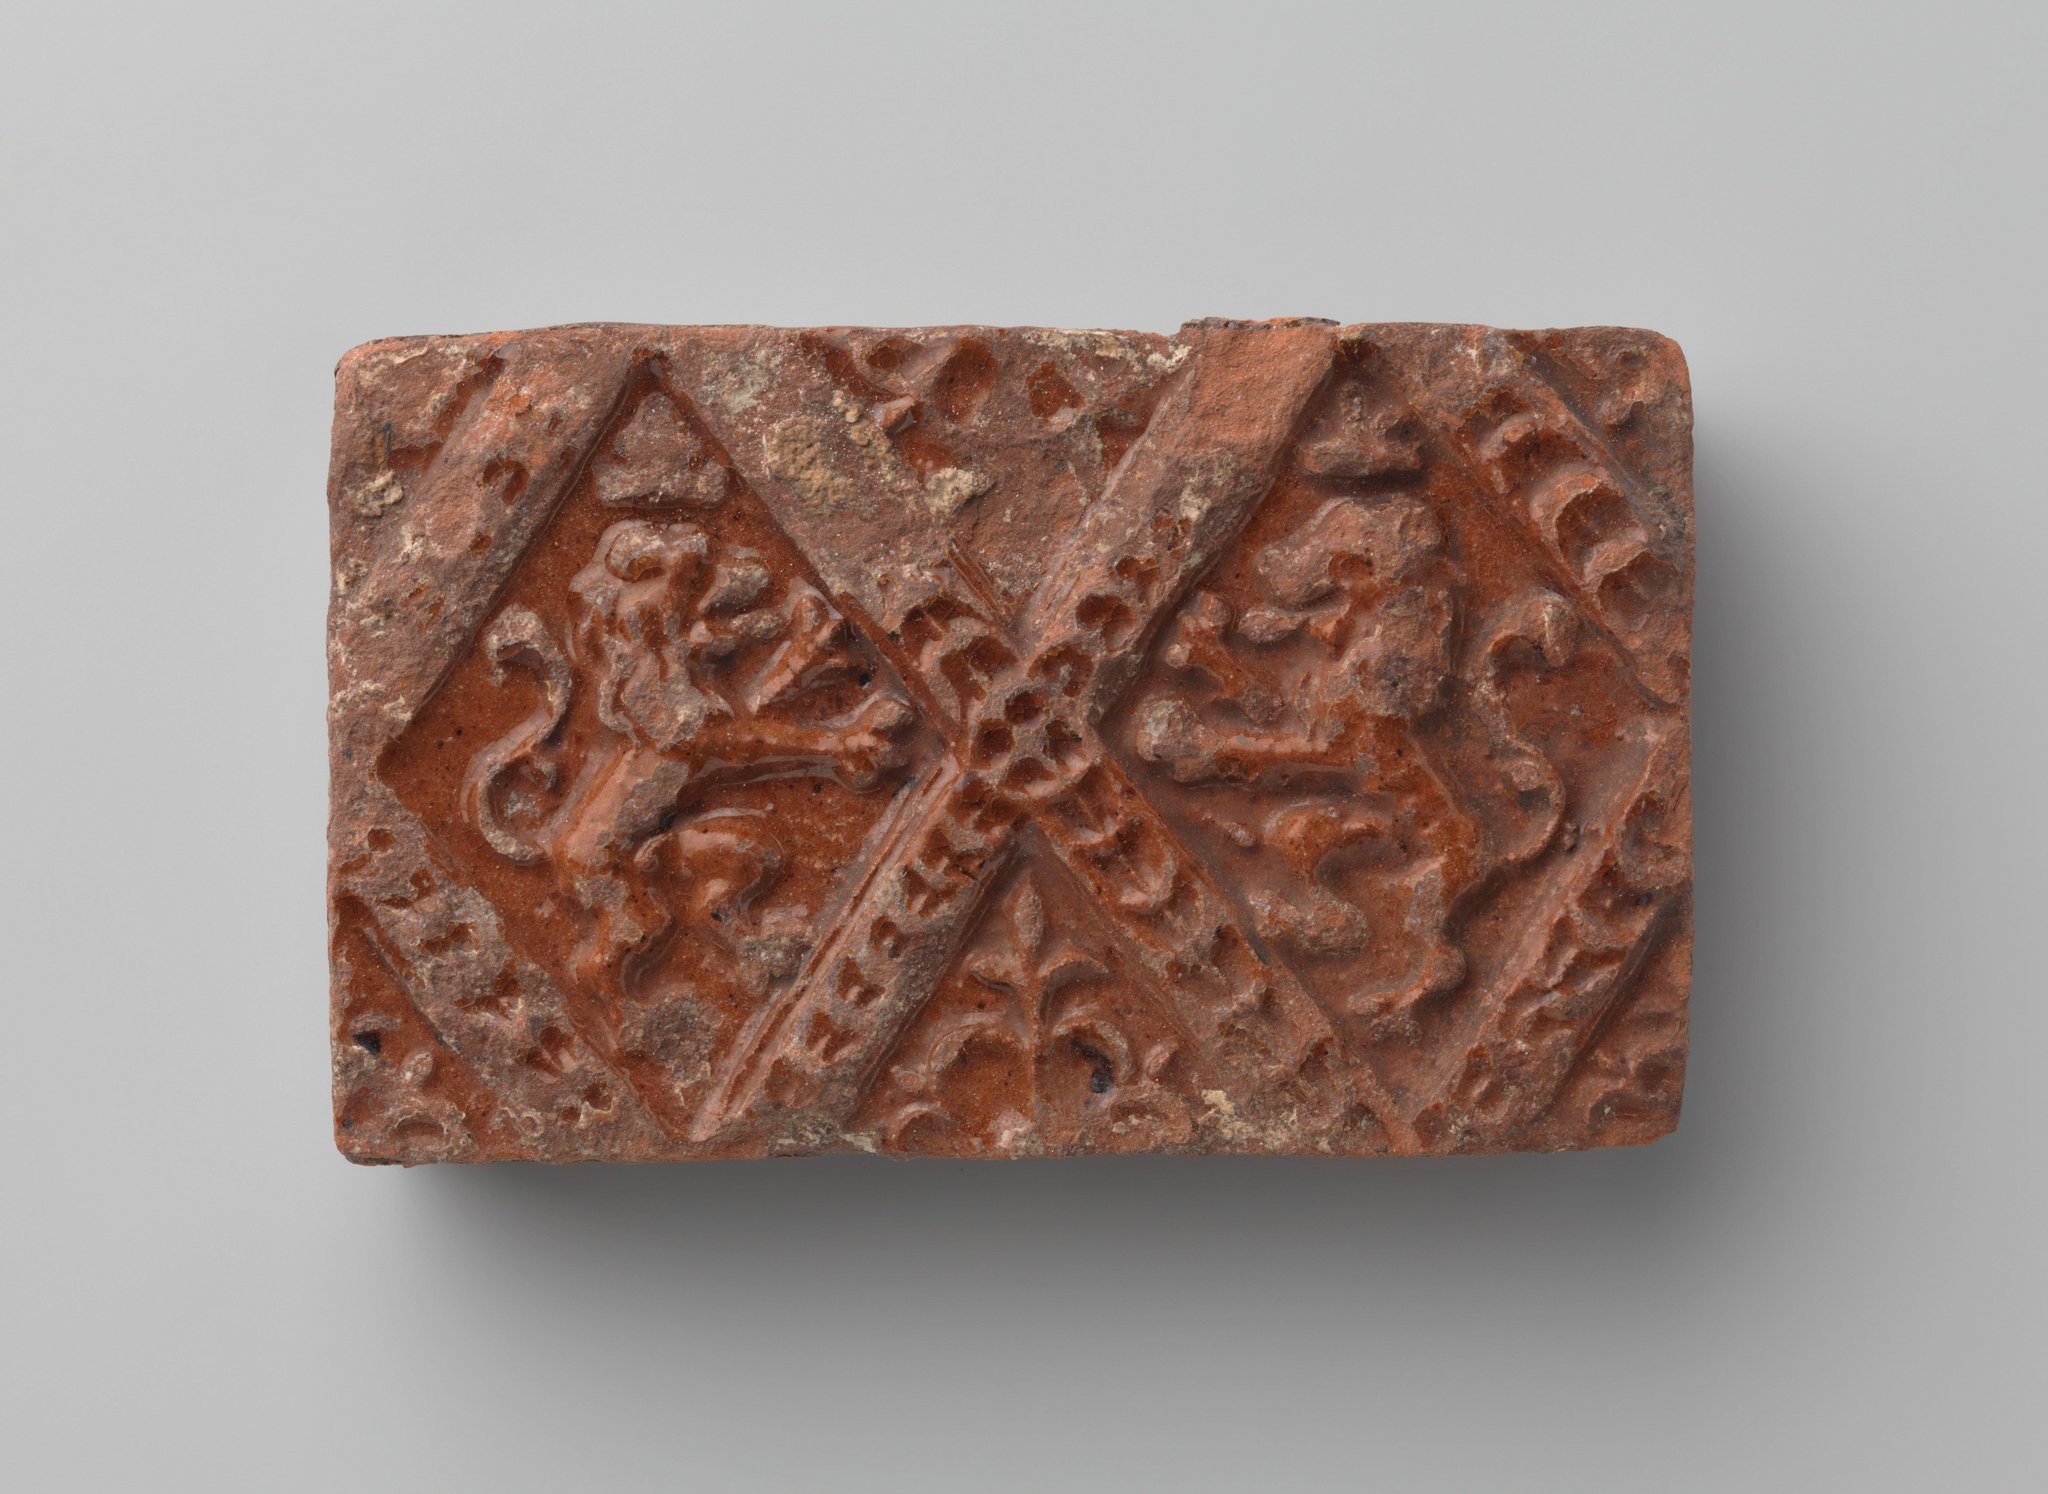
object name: hearthstone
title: Haardsteen met voorstelling van twee klimmende leeuwen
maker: Anonymous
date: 1875-1900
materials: earthenware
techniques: printing, firing, vitrification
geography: netherlands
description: Haardsteen met voorstelling van twee klimmende leeuwen, geplaatst in geprofileerde ruit. De halve ruiten aan de boven- en onderkant zijn opgevuld met pijlmotief. Geglazuurd.